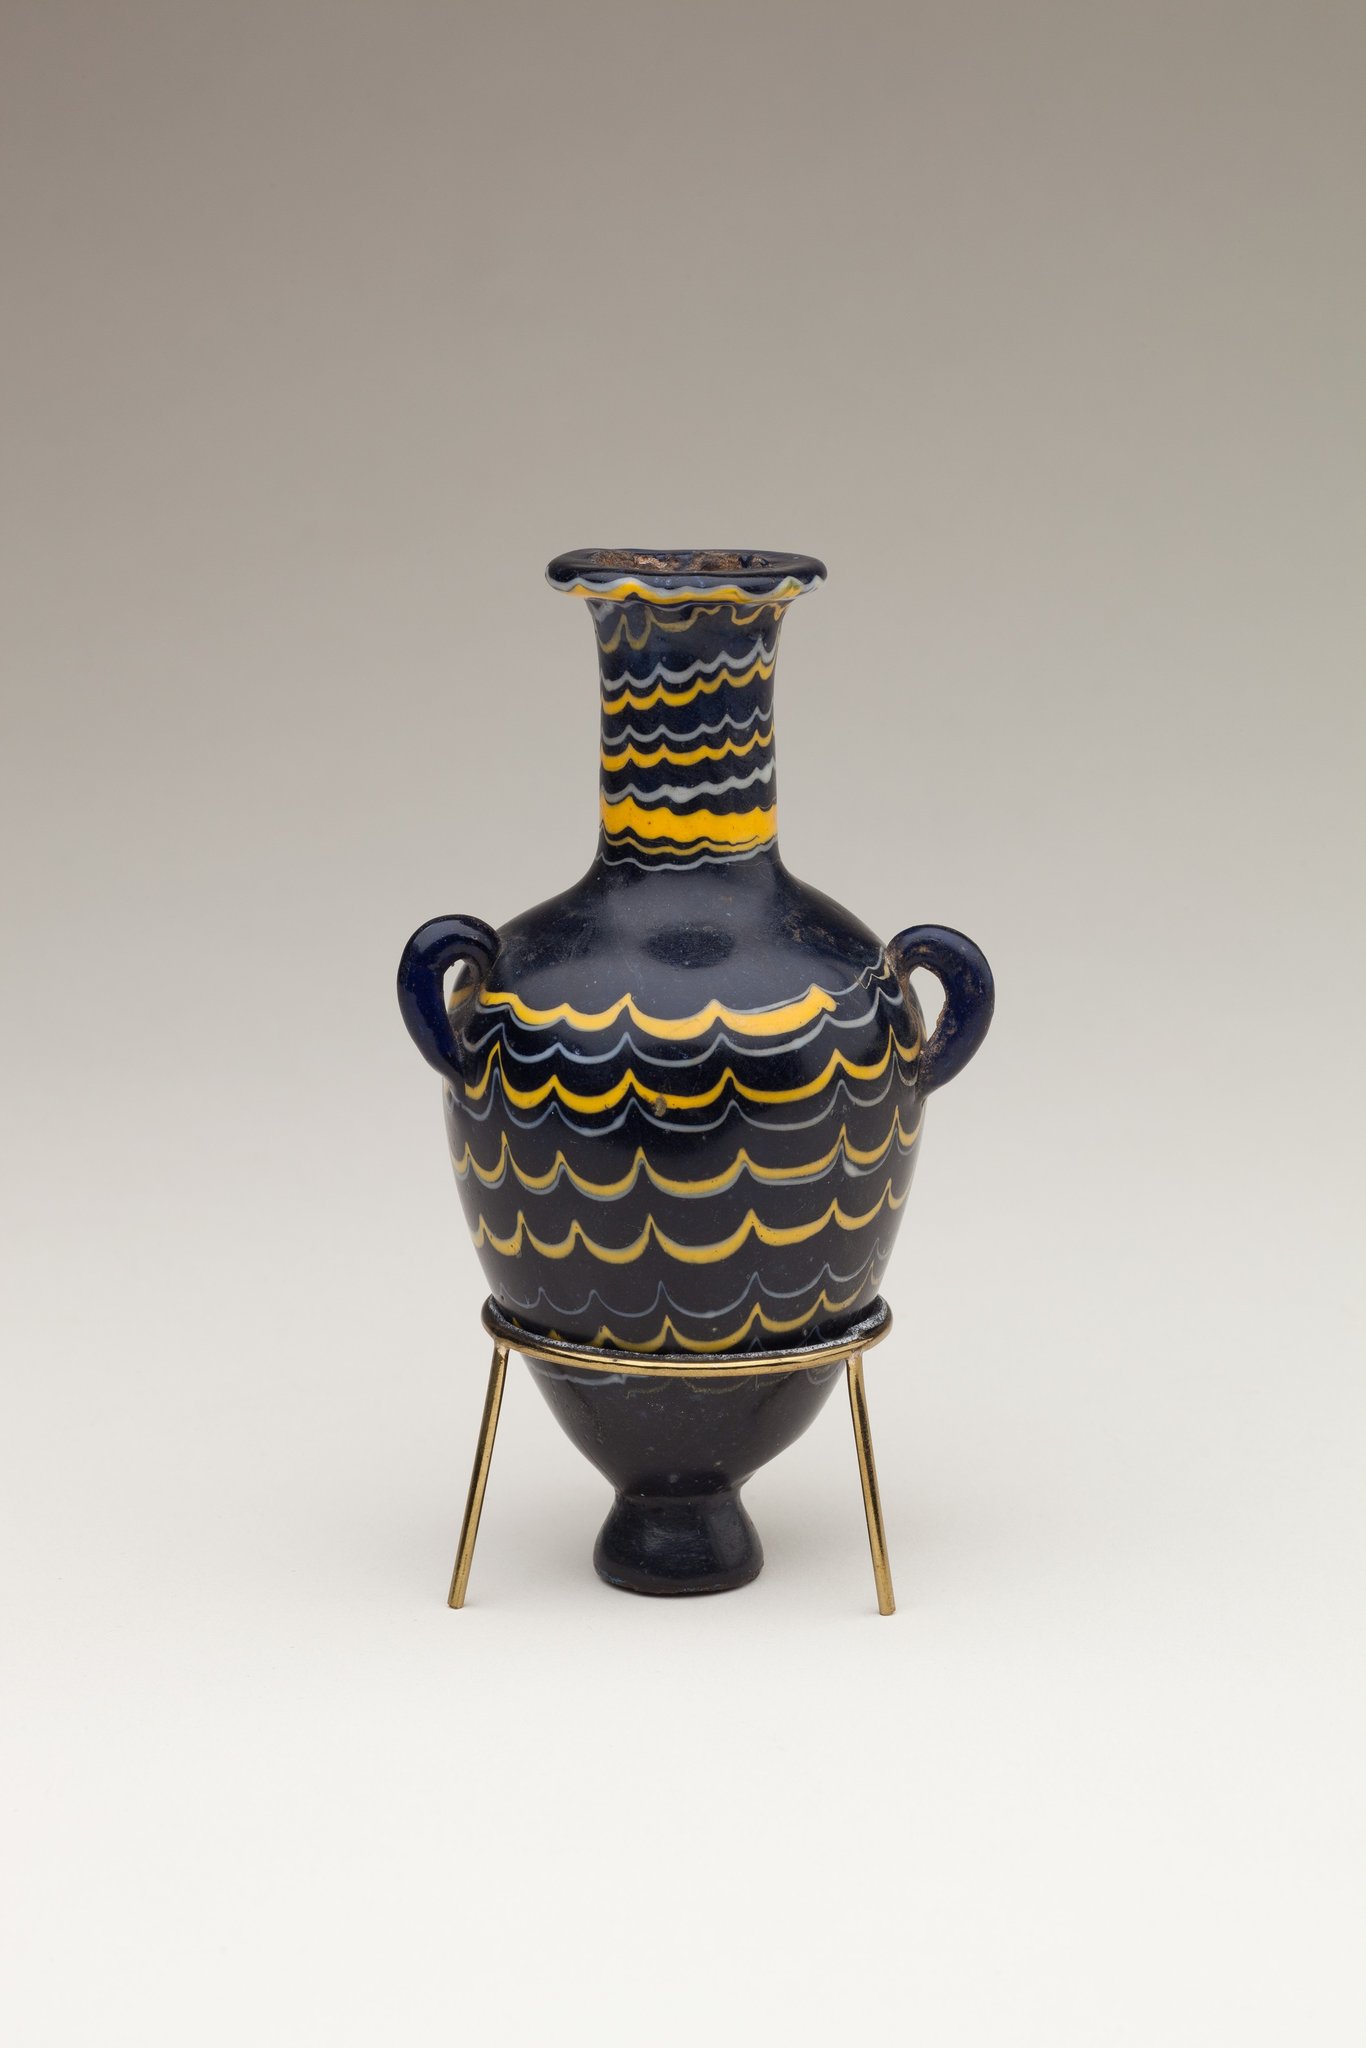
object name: amphoriskos, three handle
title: Three-Handled Amphoriskos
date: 1427-1352 BCE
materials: glass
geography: egypt